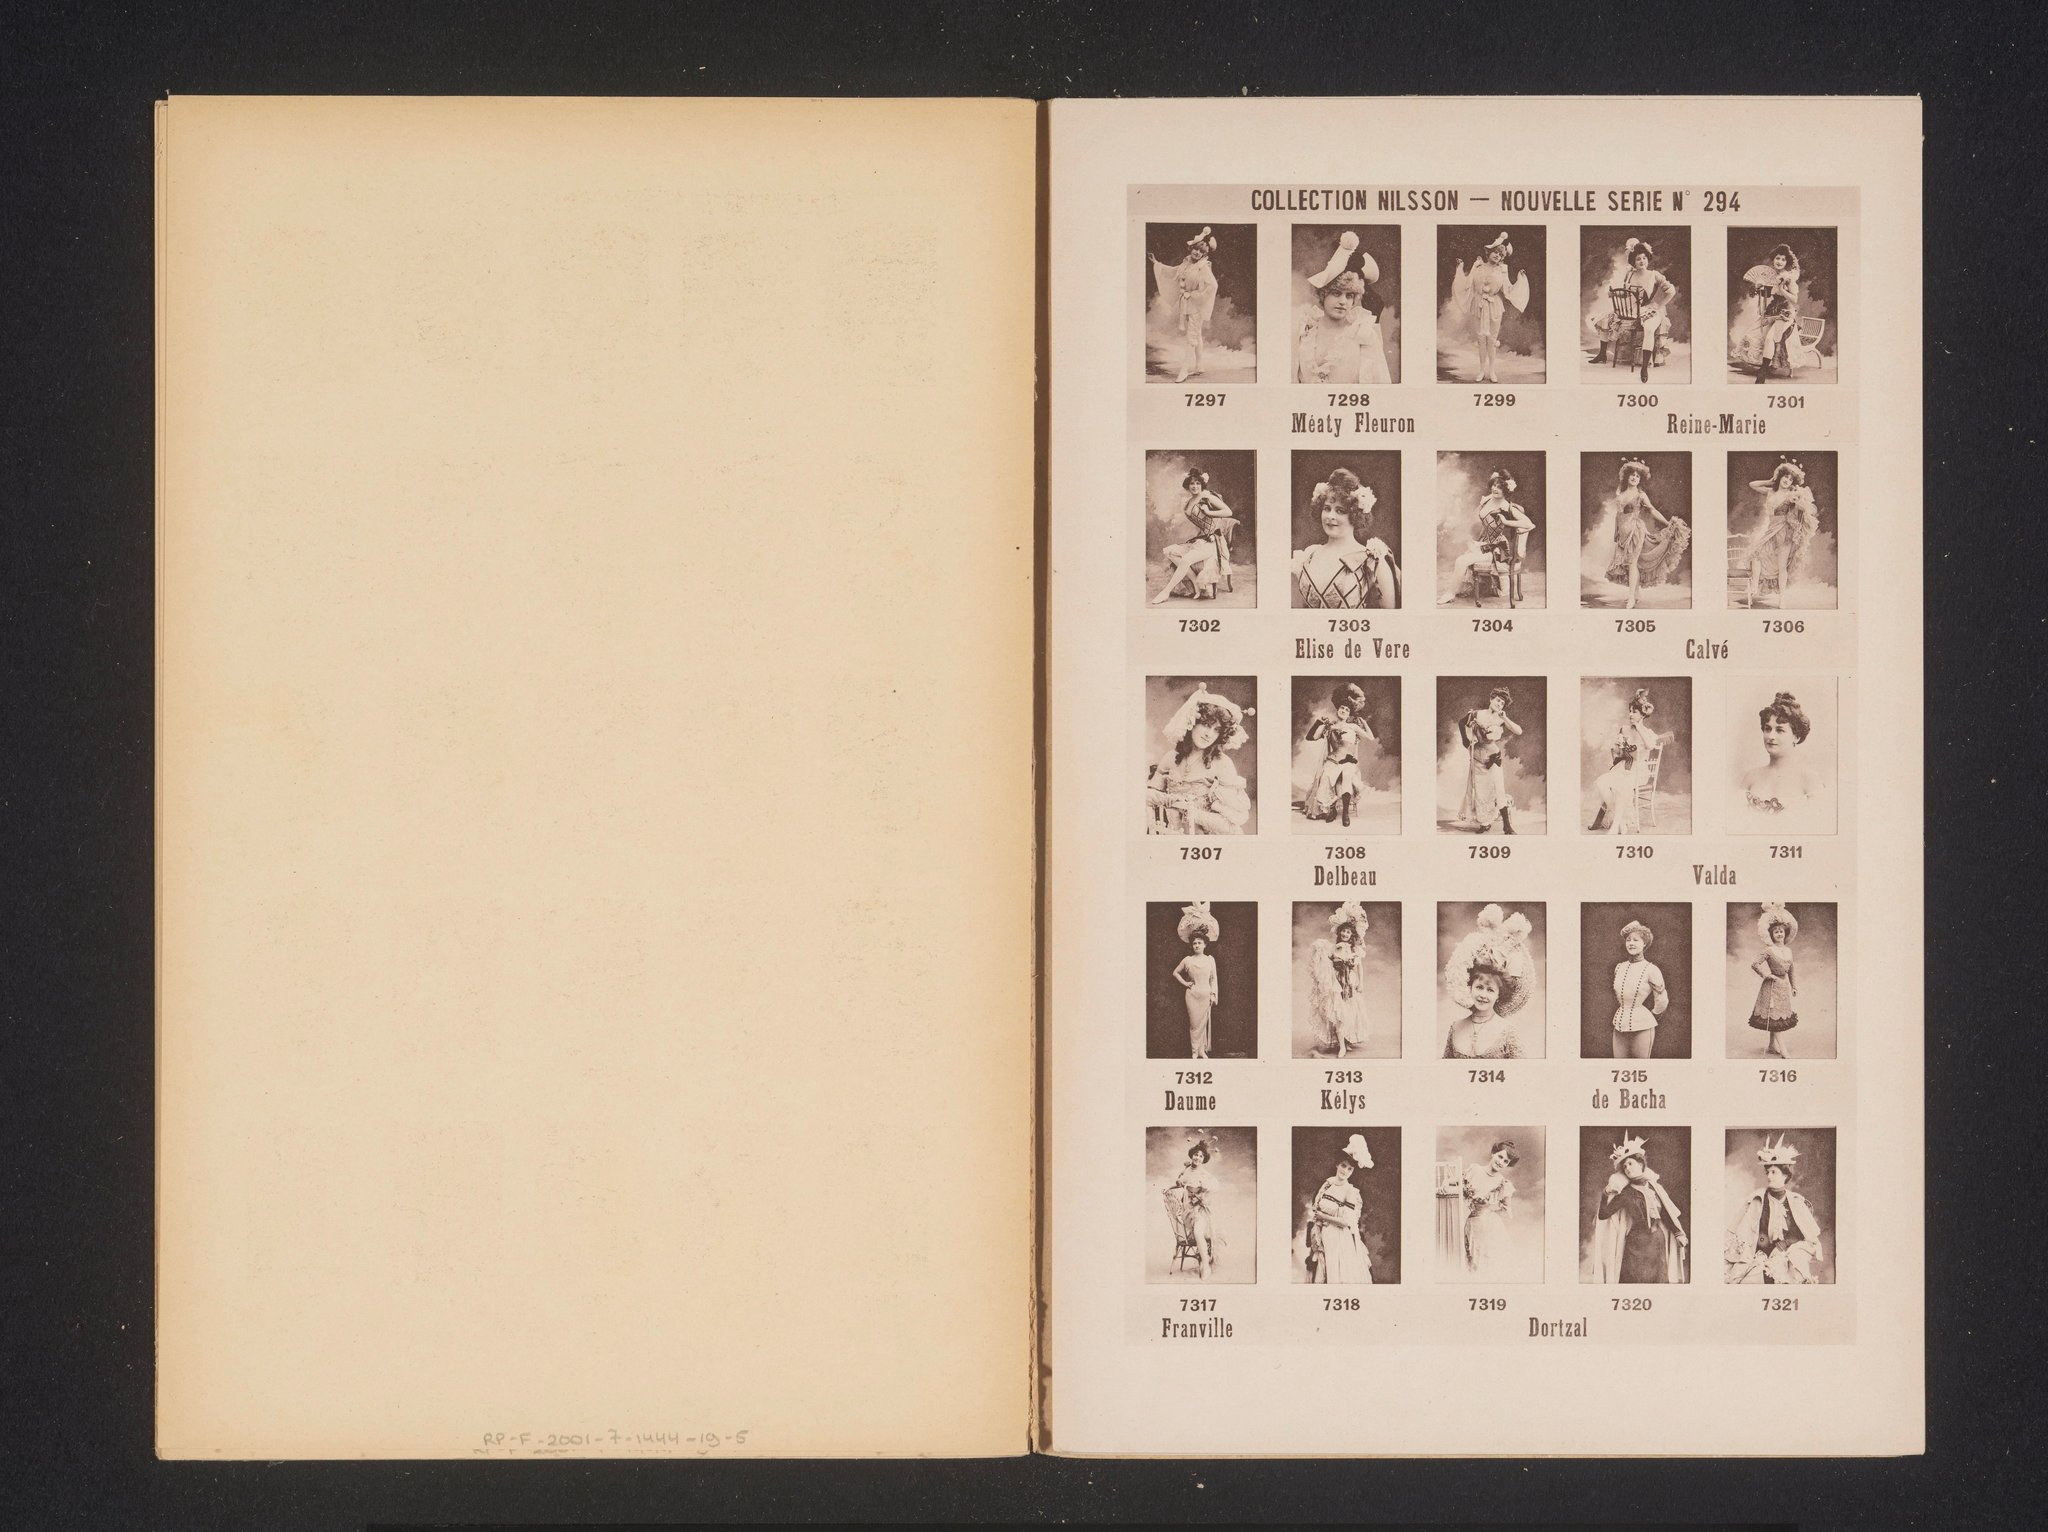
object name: photomechanical print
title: Collection Nilsson - Nouvelle Série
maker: Anonymous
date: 1895-1900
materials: paper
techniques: photograph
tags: historical persons - bb - woman, portrait of actor, actress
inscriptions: number: ‘No 294’, inscription: ‘Méaty Fleuron Reine-Marie/ Elise de Vere Calvé/ Delbeau Valda/ Daume Kélys de Bacha/ Franville Dortzal’